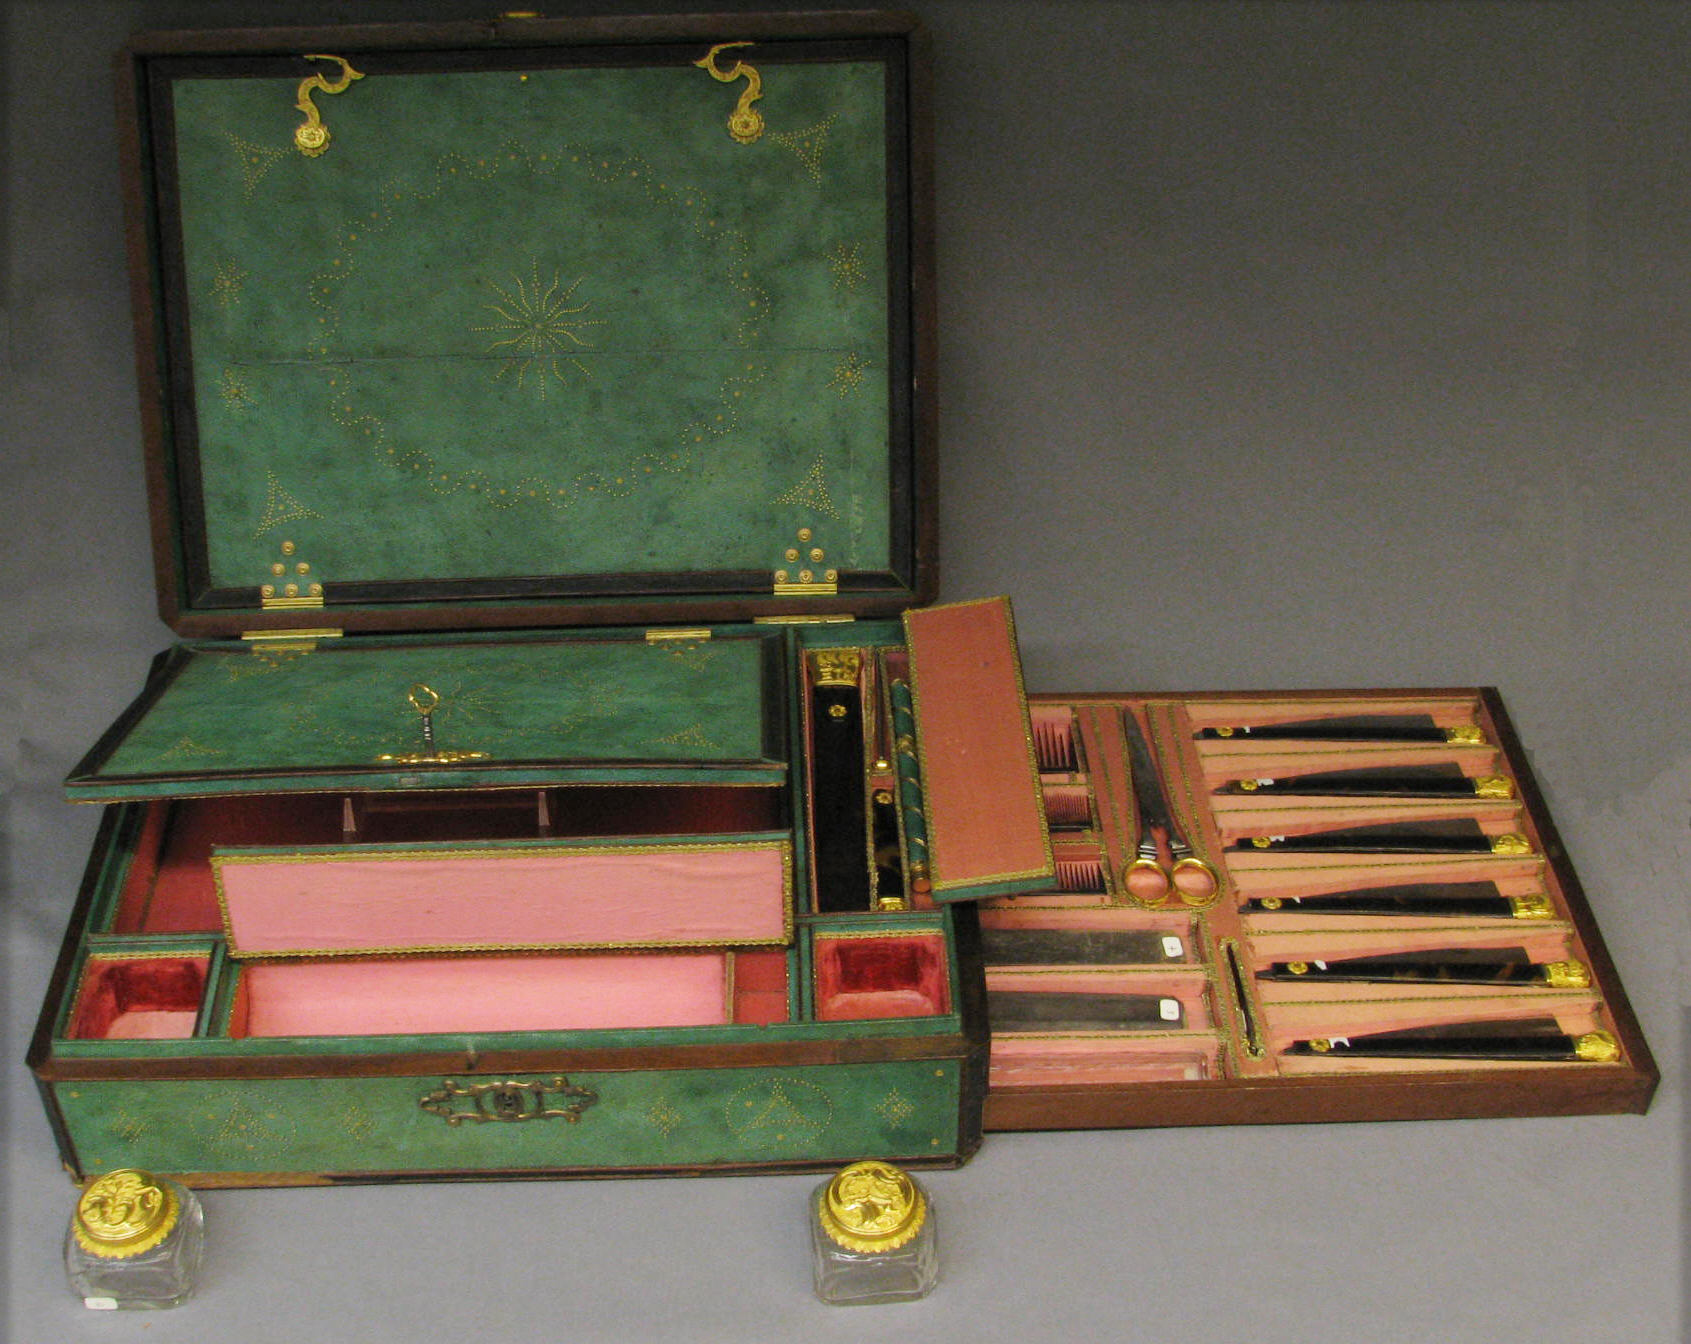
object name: nécessaire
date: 1734-1766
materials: gold, silk, steel, shell, wood